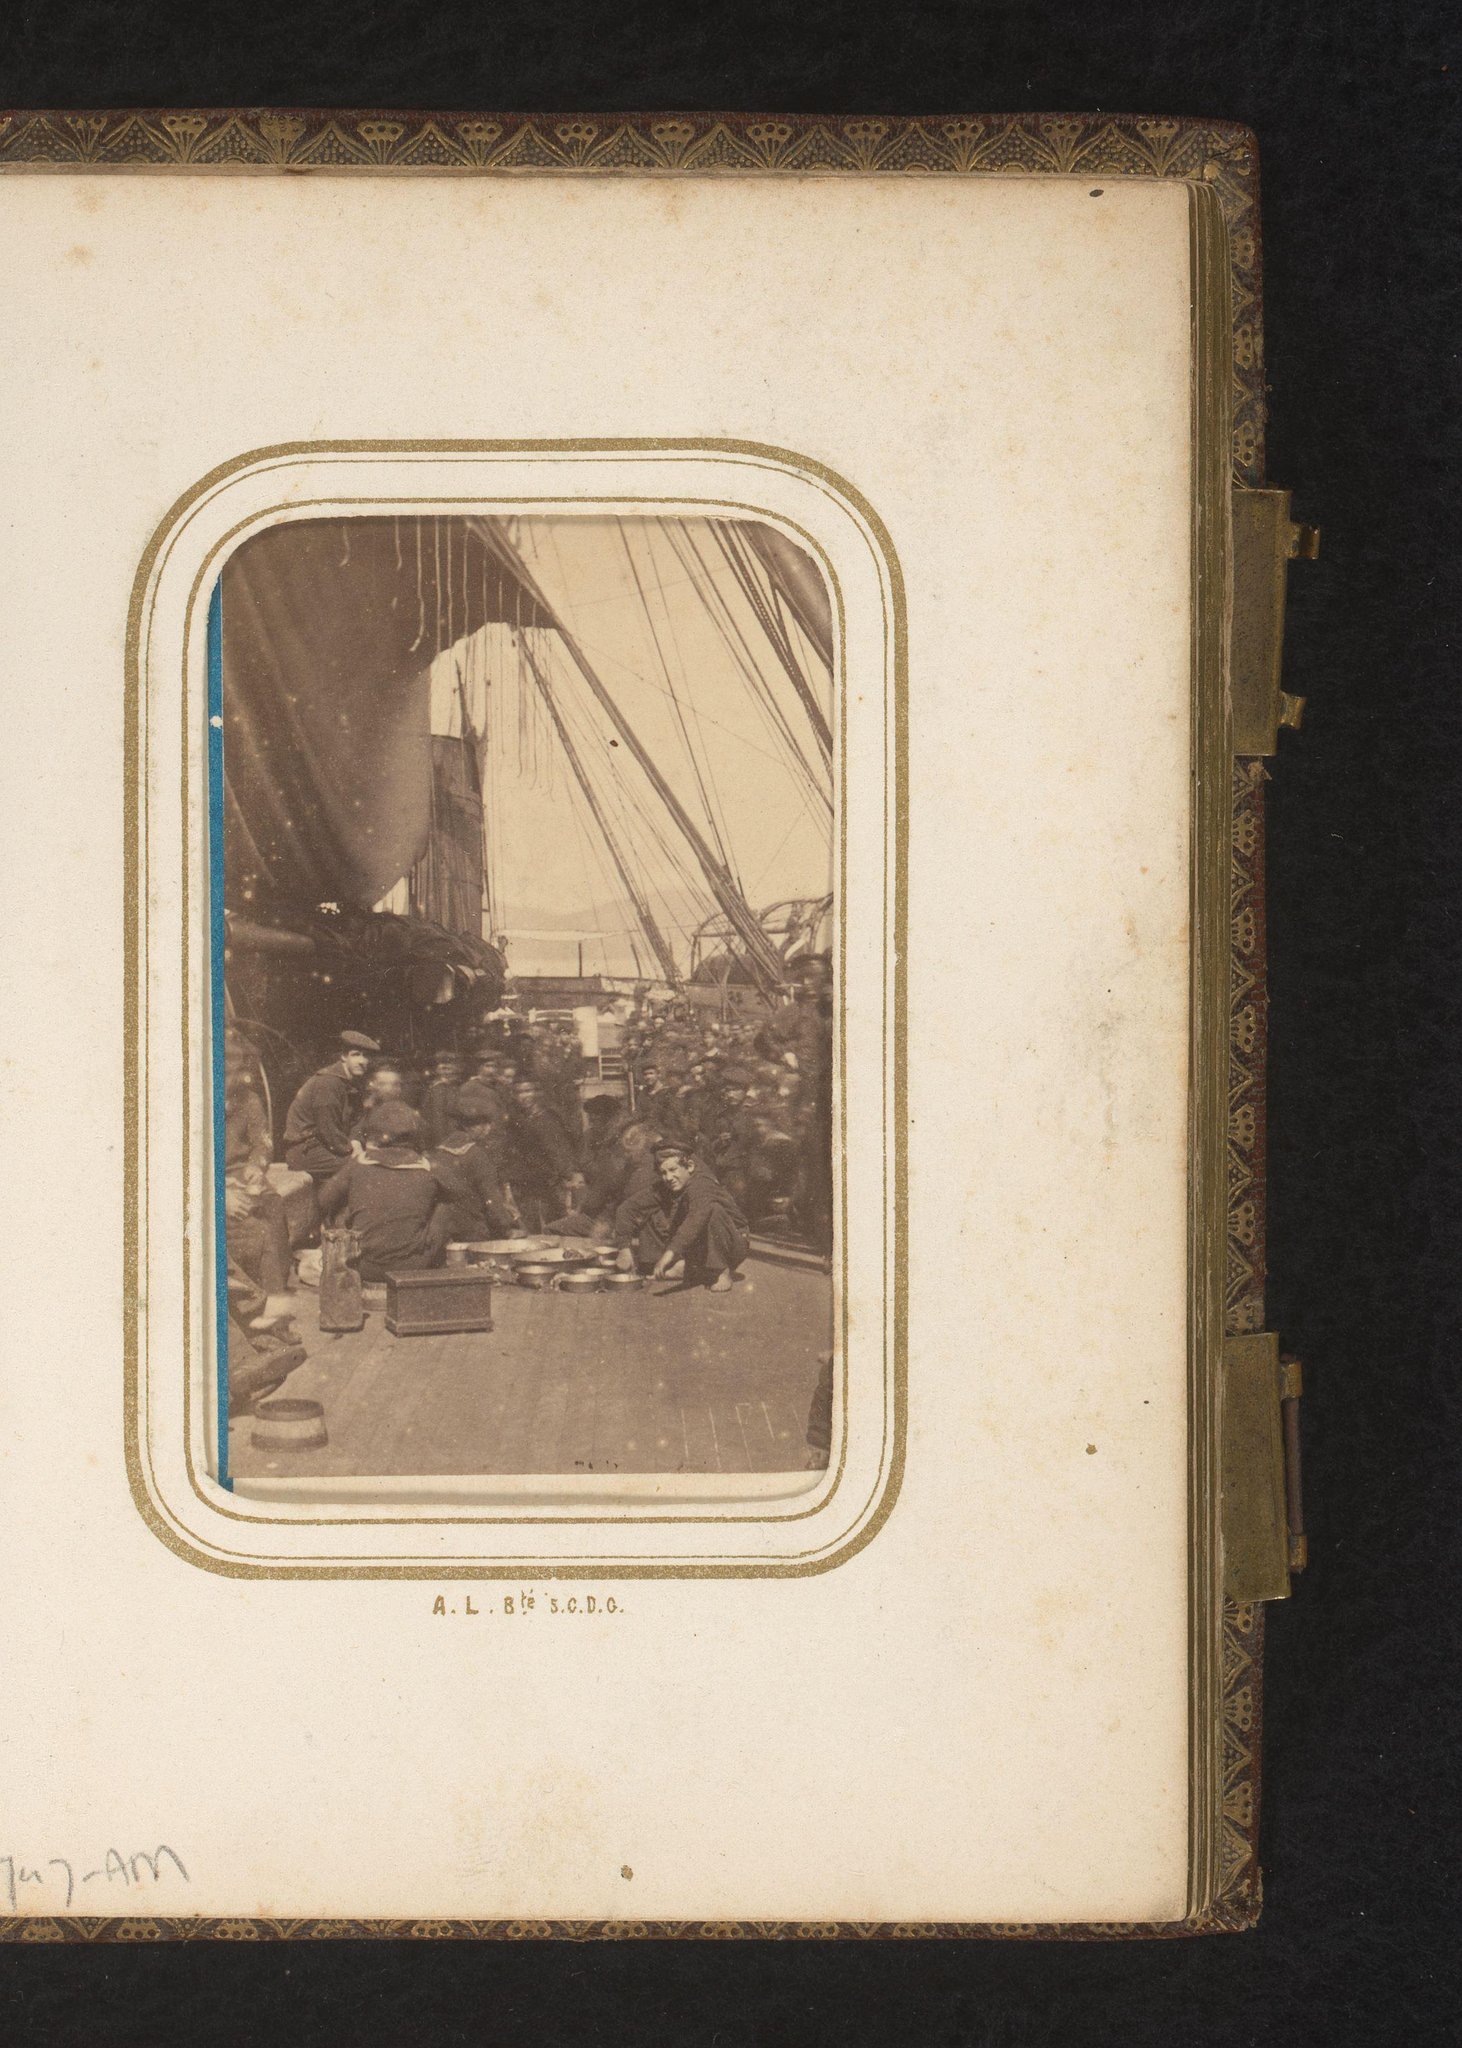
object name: album leaf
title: Bemanningsleden aan dek van een schip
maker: Anonymous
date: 1860-1890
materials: cardboard, photographic support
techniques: albumen print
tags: crew ~ ship, kitchen-utensils, parts of ship's exterior: deck, ships (in general)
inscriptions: inscription: ‘A.L. B.te S.C.D.G.’